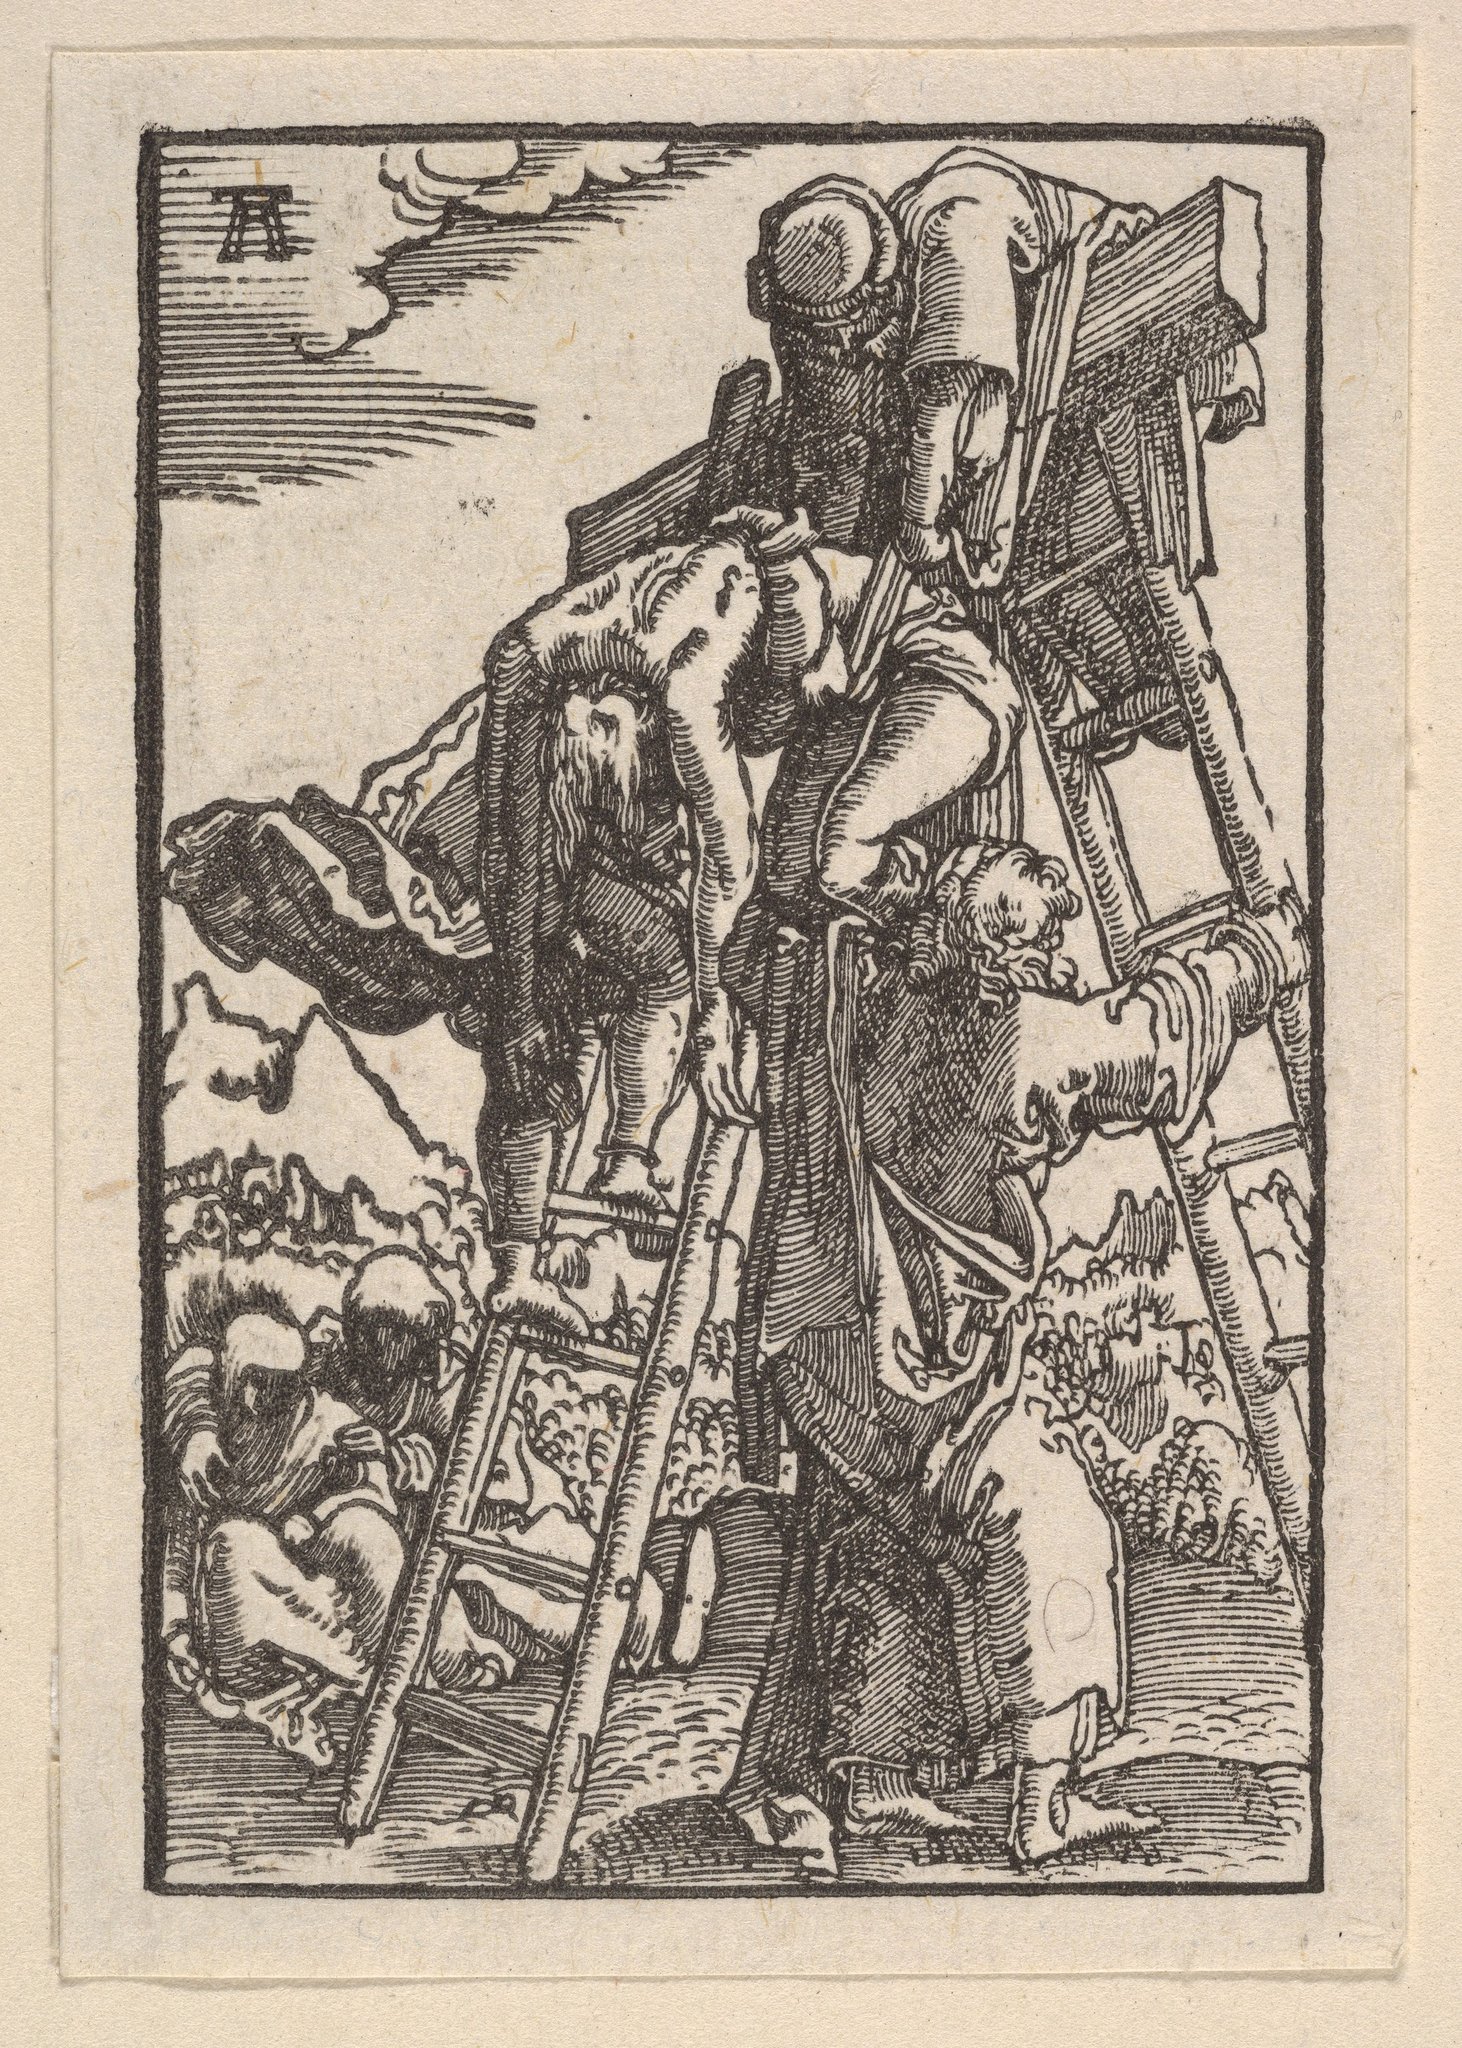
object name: print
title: The Descent from the Cross, from "The Fall and Salvation of Mankind Through the Life and Passion of Christ"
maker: albrecht altdorfer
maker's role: artist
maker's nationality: german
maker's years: 1480-1538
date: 1513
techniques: woodcut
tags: christ,cross,descent from the cross,ladders